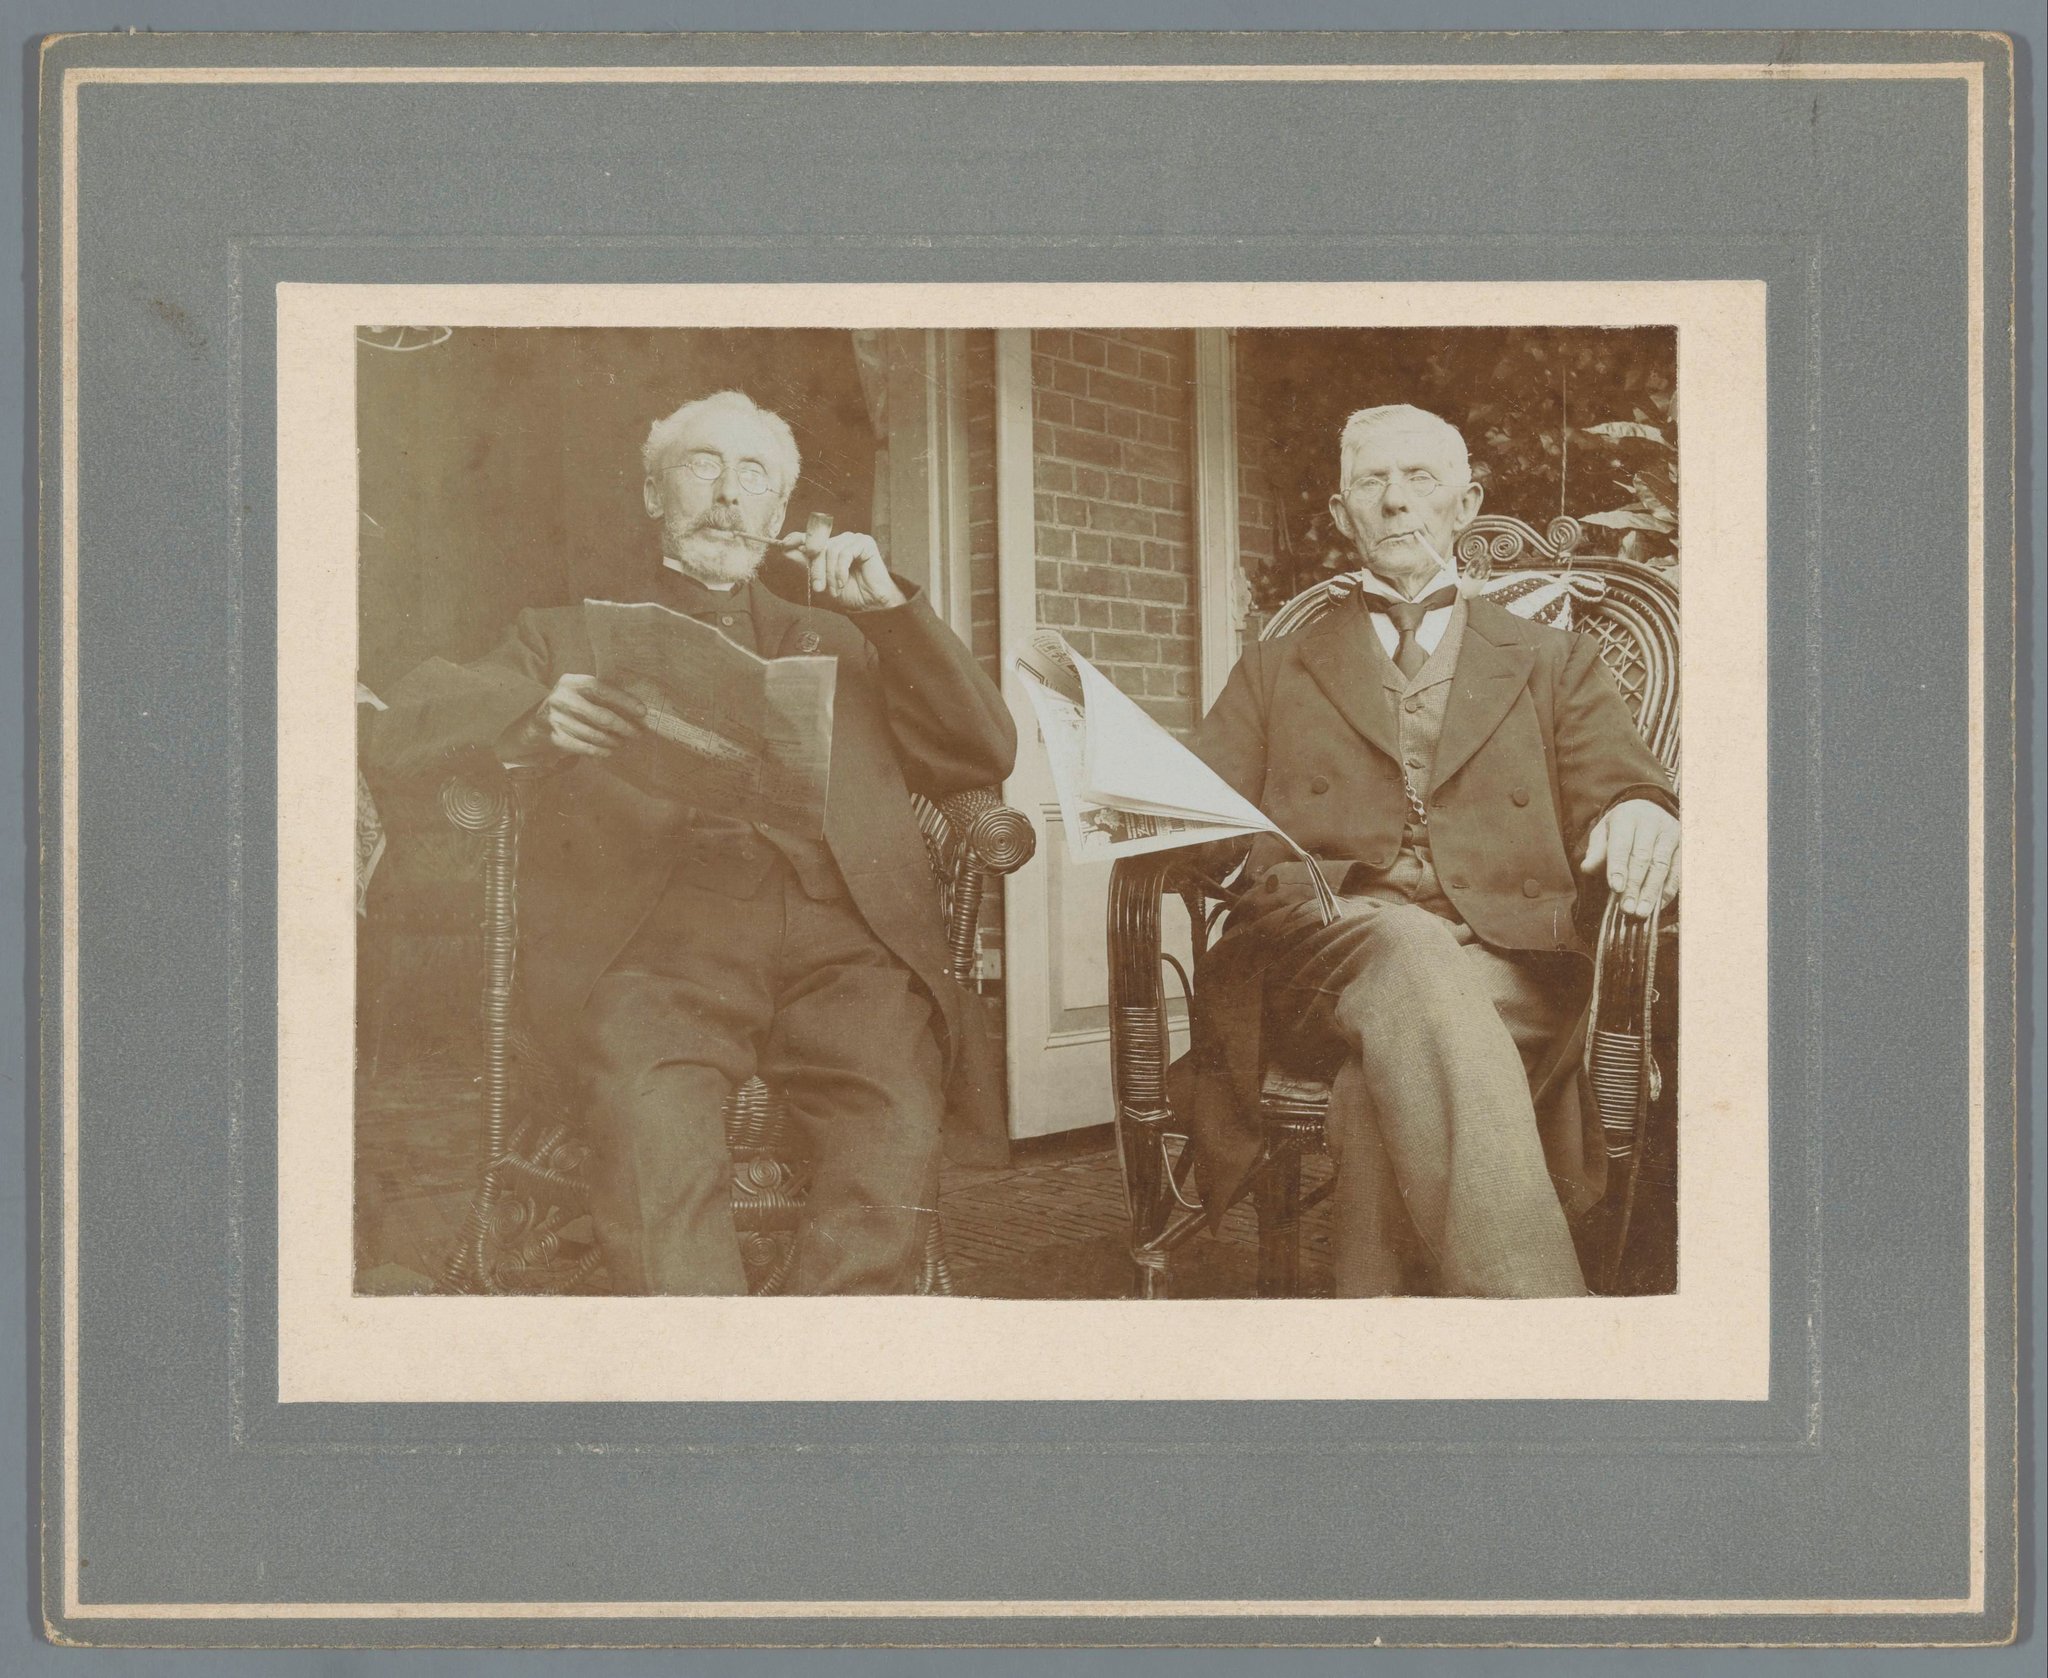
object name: photograph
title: Portret van twee rokende mannen met een krant in een tuin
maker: Anonymous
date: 1908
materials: cardboard, photographic support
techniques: collodion silver print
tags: old man, newspaper, news-sheet, tobacco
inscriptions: inscription: ‘Aug. 1908’